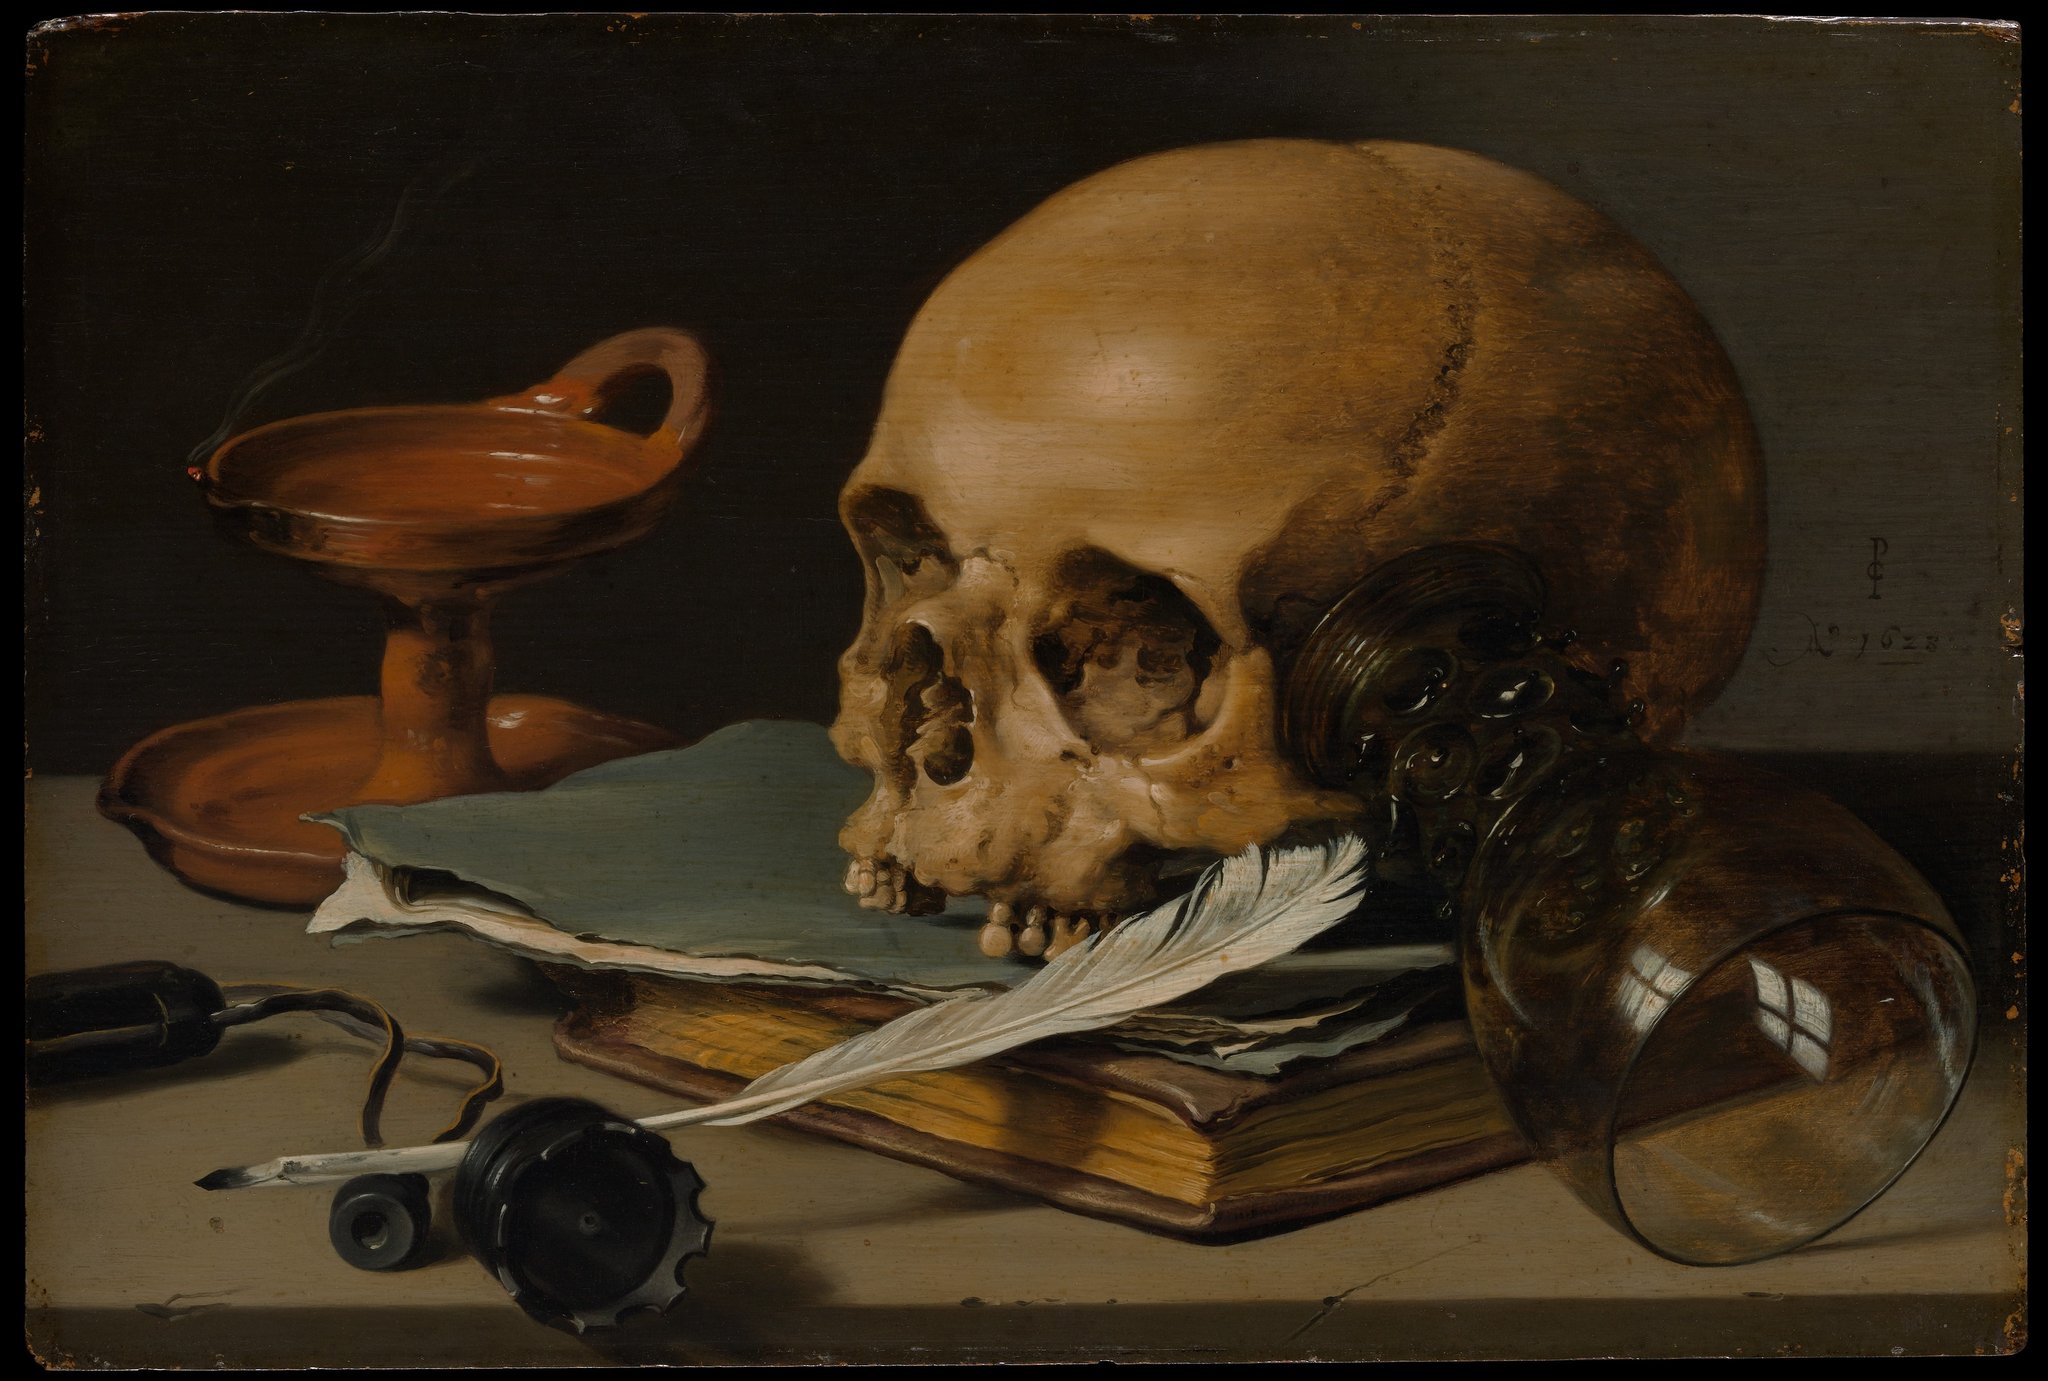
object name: painting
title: Still Life with a Skull and a Writing Quill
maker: pieter claesz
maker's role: artist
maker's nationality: dutch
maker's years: 1596-1660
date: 1628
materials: oil, wood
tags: books,skulls,still life,drinking glasses,lamps